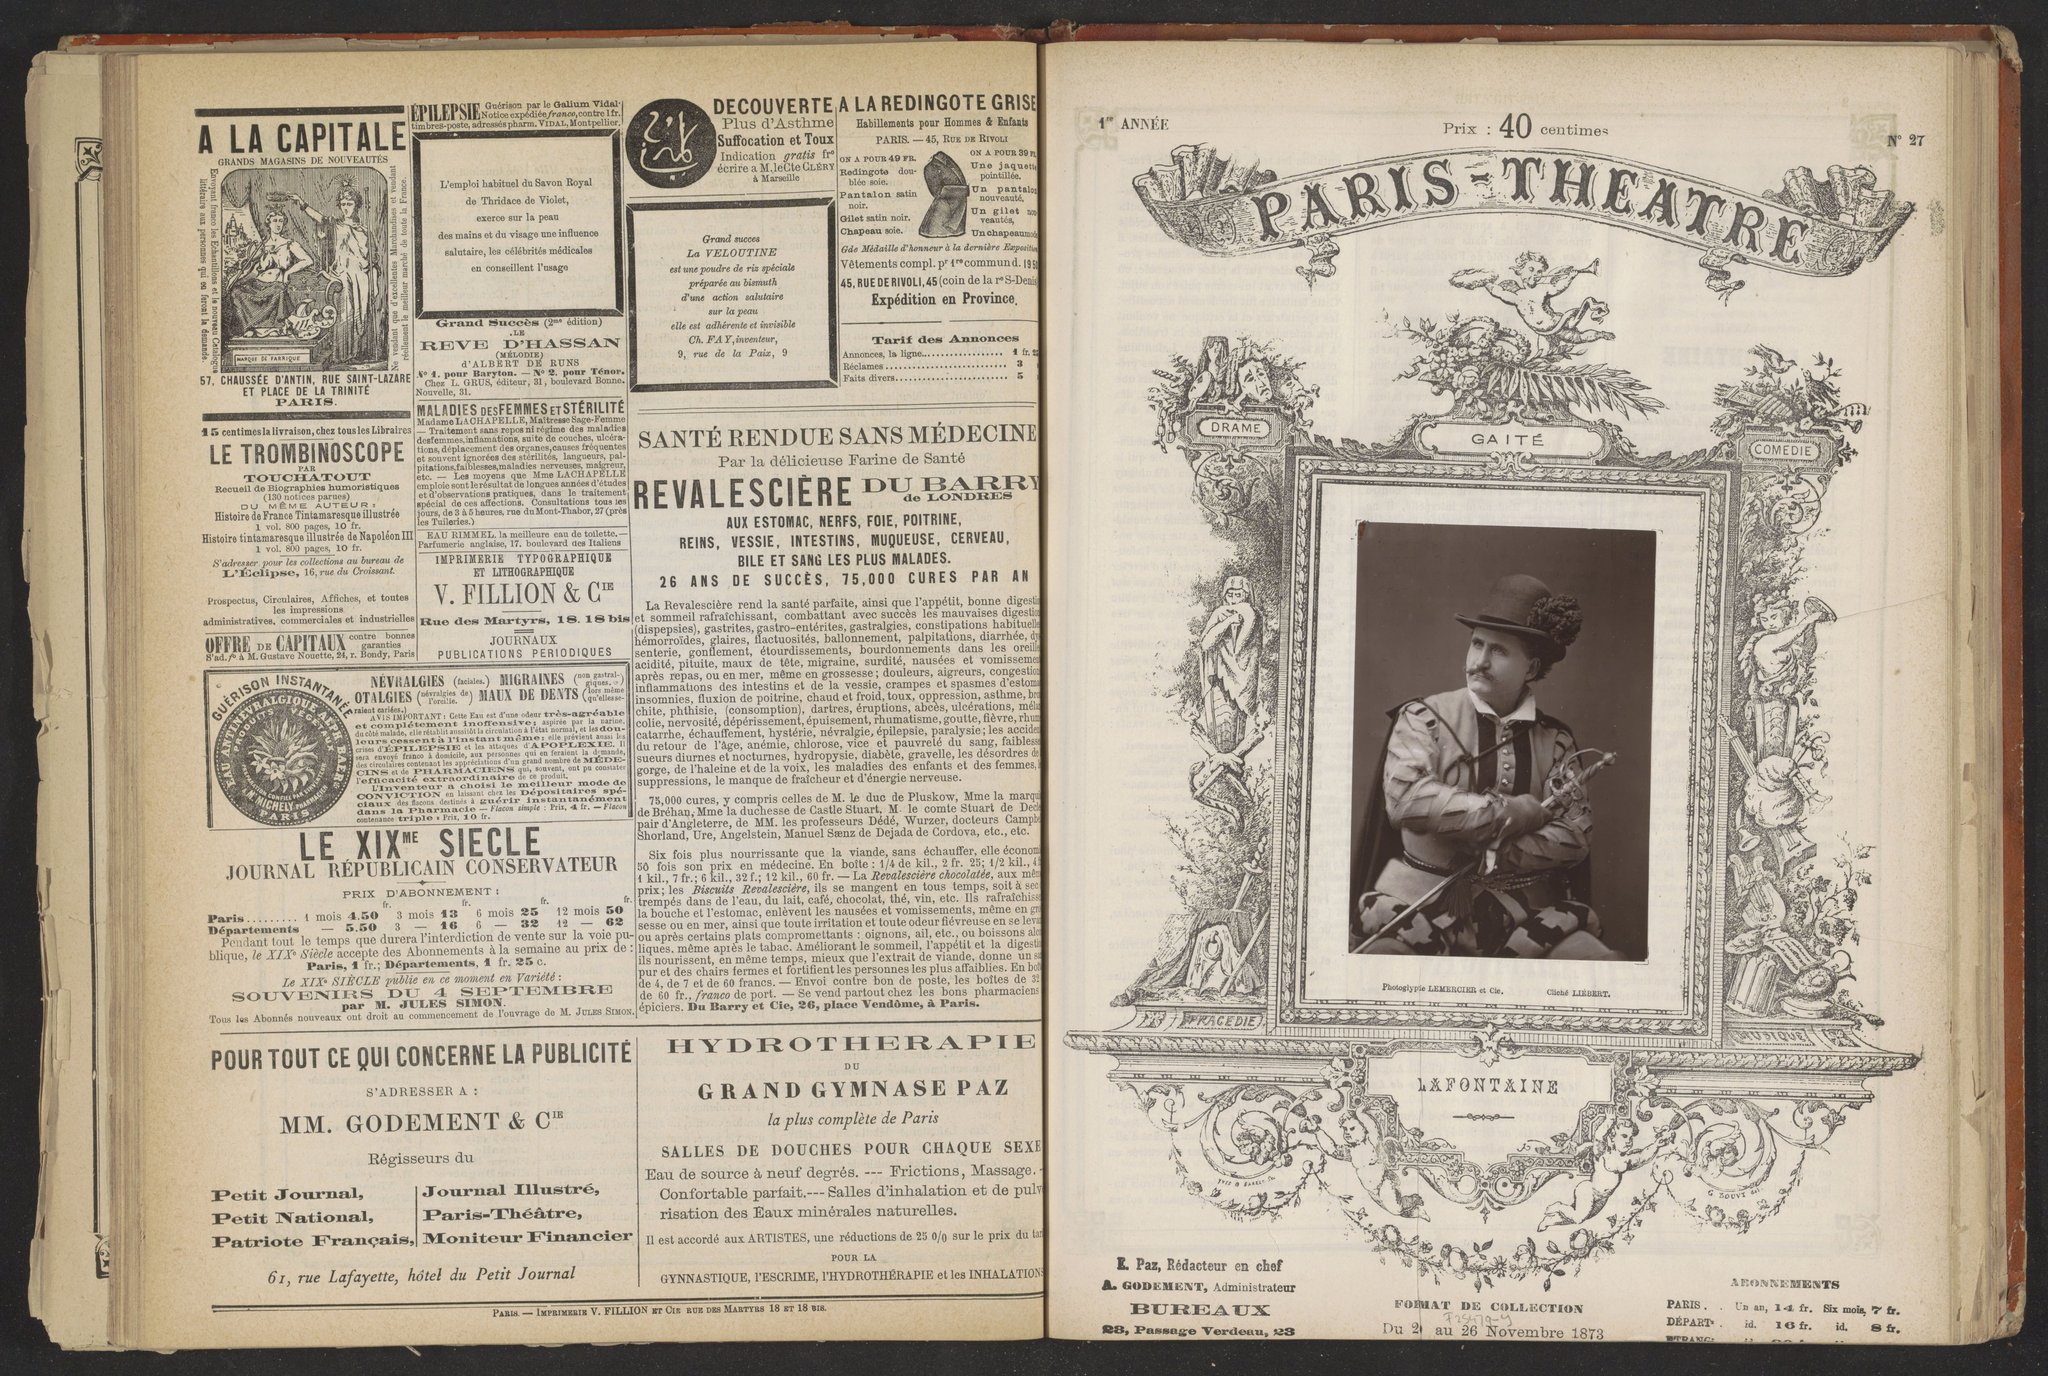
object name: photomechanical print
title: Portret van Lafontaine als Gascon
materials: paper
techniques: woodburytype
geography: france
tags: portrait of actor, actress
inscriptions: inscription: ‘Du 20 au 26 Novembre 1873.’, number: ‘No 27’